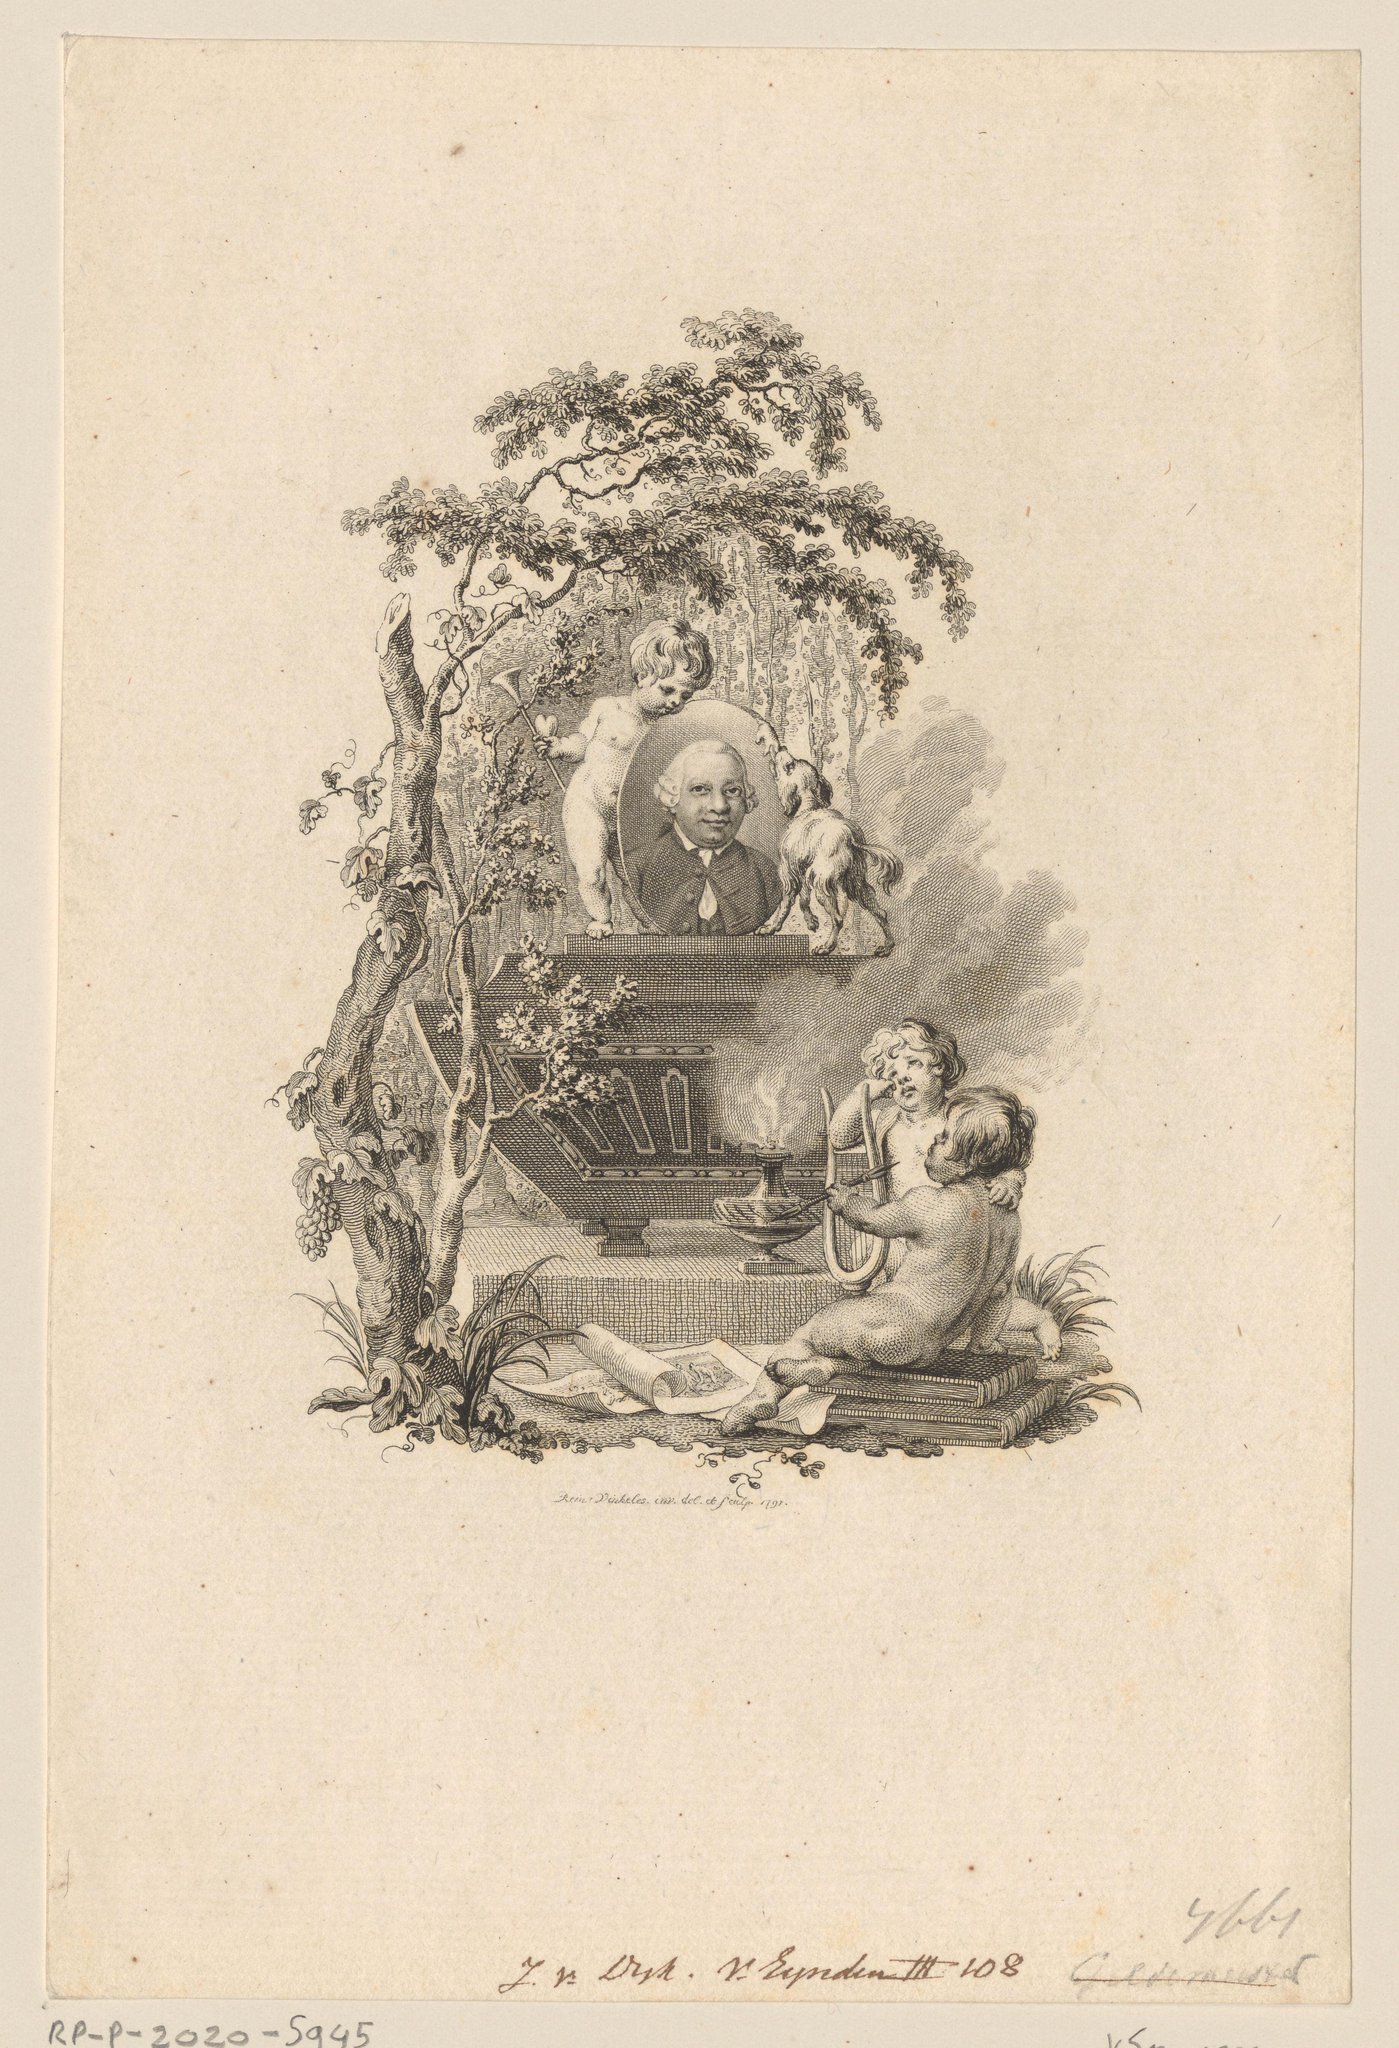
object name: print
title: Portret van Jan van Dijk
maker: reinier vinkeles (i)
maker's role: draughtsman, print maker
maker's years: 1741-1816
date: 1791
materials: paper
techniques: etching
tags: historical persons, art collector, grave, tomb, weeping, incense-burner ~ scents, perfumes, cupids: 'amores', 'amoretti', 'putti', dog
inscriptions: inscription: ‘J. v. Dijk. v. Eynden III 108’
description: Prent mogelijk uit: Catalogus van een fraaije verzameling schilderyen door vermaarde Nederlandsche meesters. Amsterdam: Albert van der Kroe, Anthonie Capel, D.M. Langeveld en D. Huis, 1791.